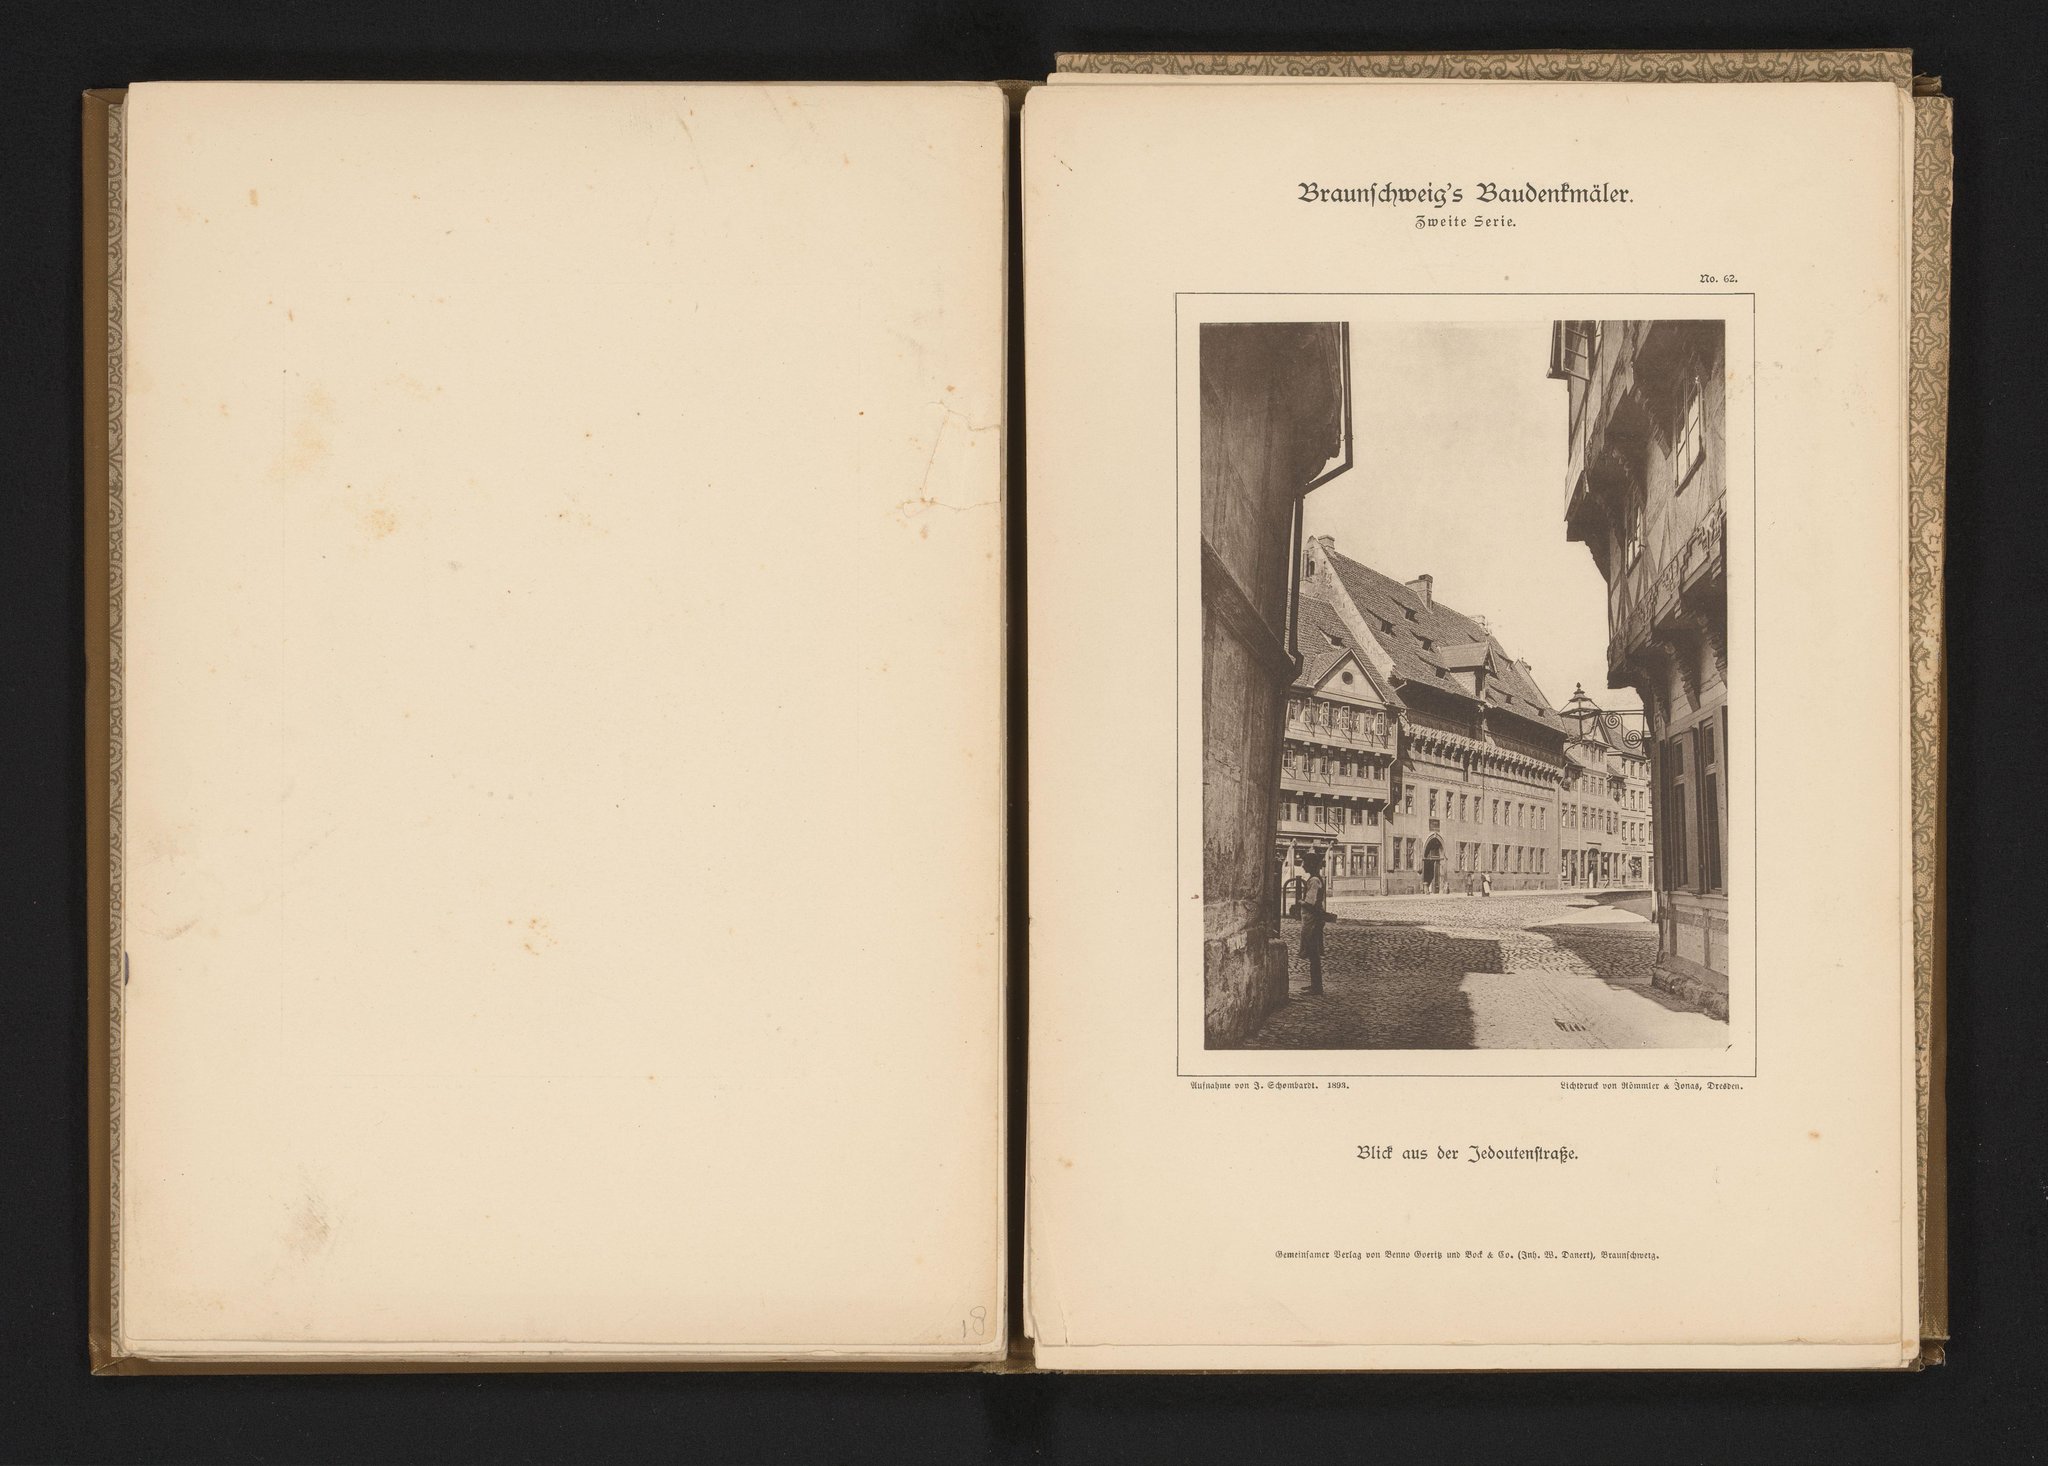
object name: page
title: Gezicht op de Jedoutenstraße te Braunschweig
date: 1893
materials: paper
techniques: photograph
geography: braunschweig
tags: façade (of house or building), street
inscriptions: number: ‘No. 62.’